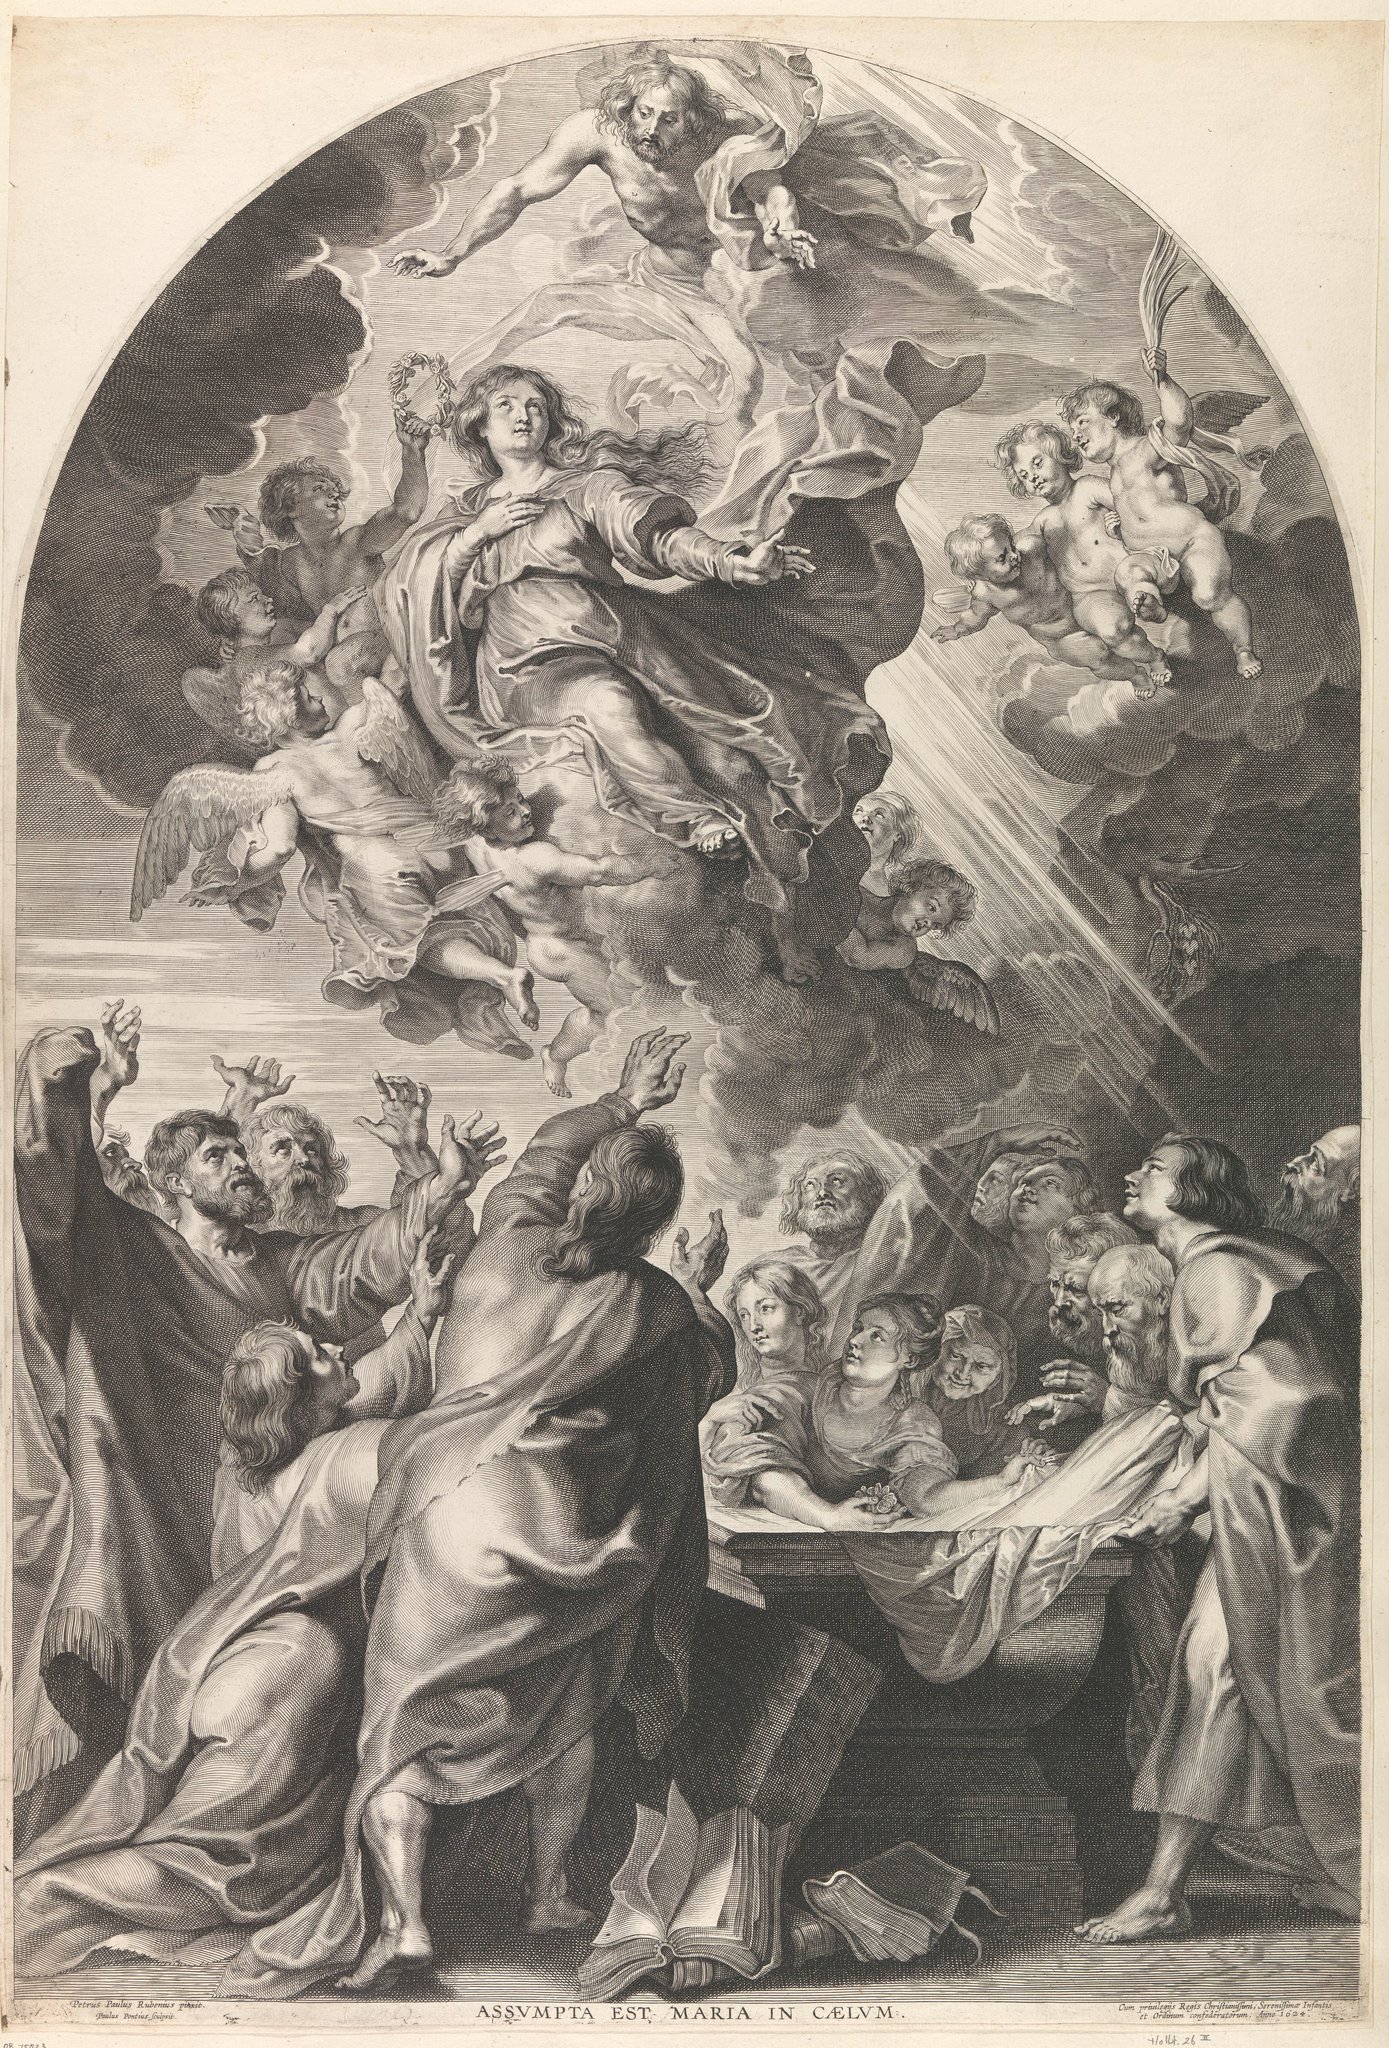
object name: album leaf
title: Assumpta est Maria in caelum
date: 1624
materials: paper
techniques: engraving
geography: antwerp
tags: the assumption of mary ('assumptio corporis'): she is borne into heaven by angels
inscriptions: date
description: Deze prent maakt deel uit van een album.